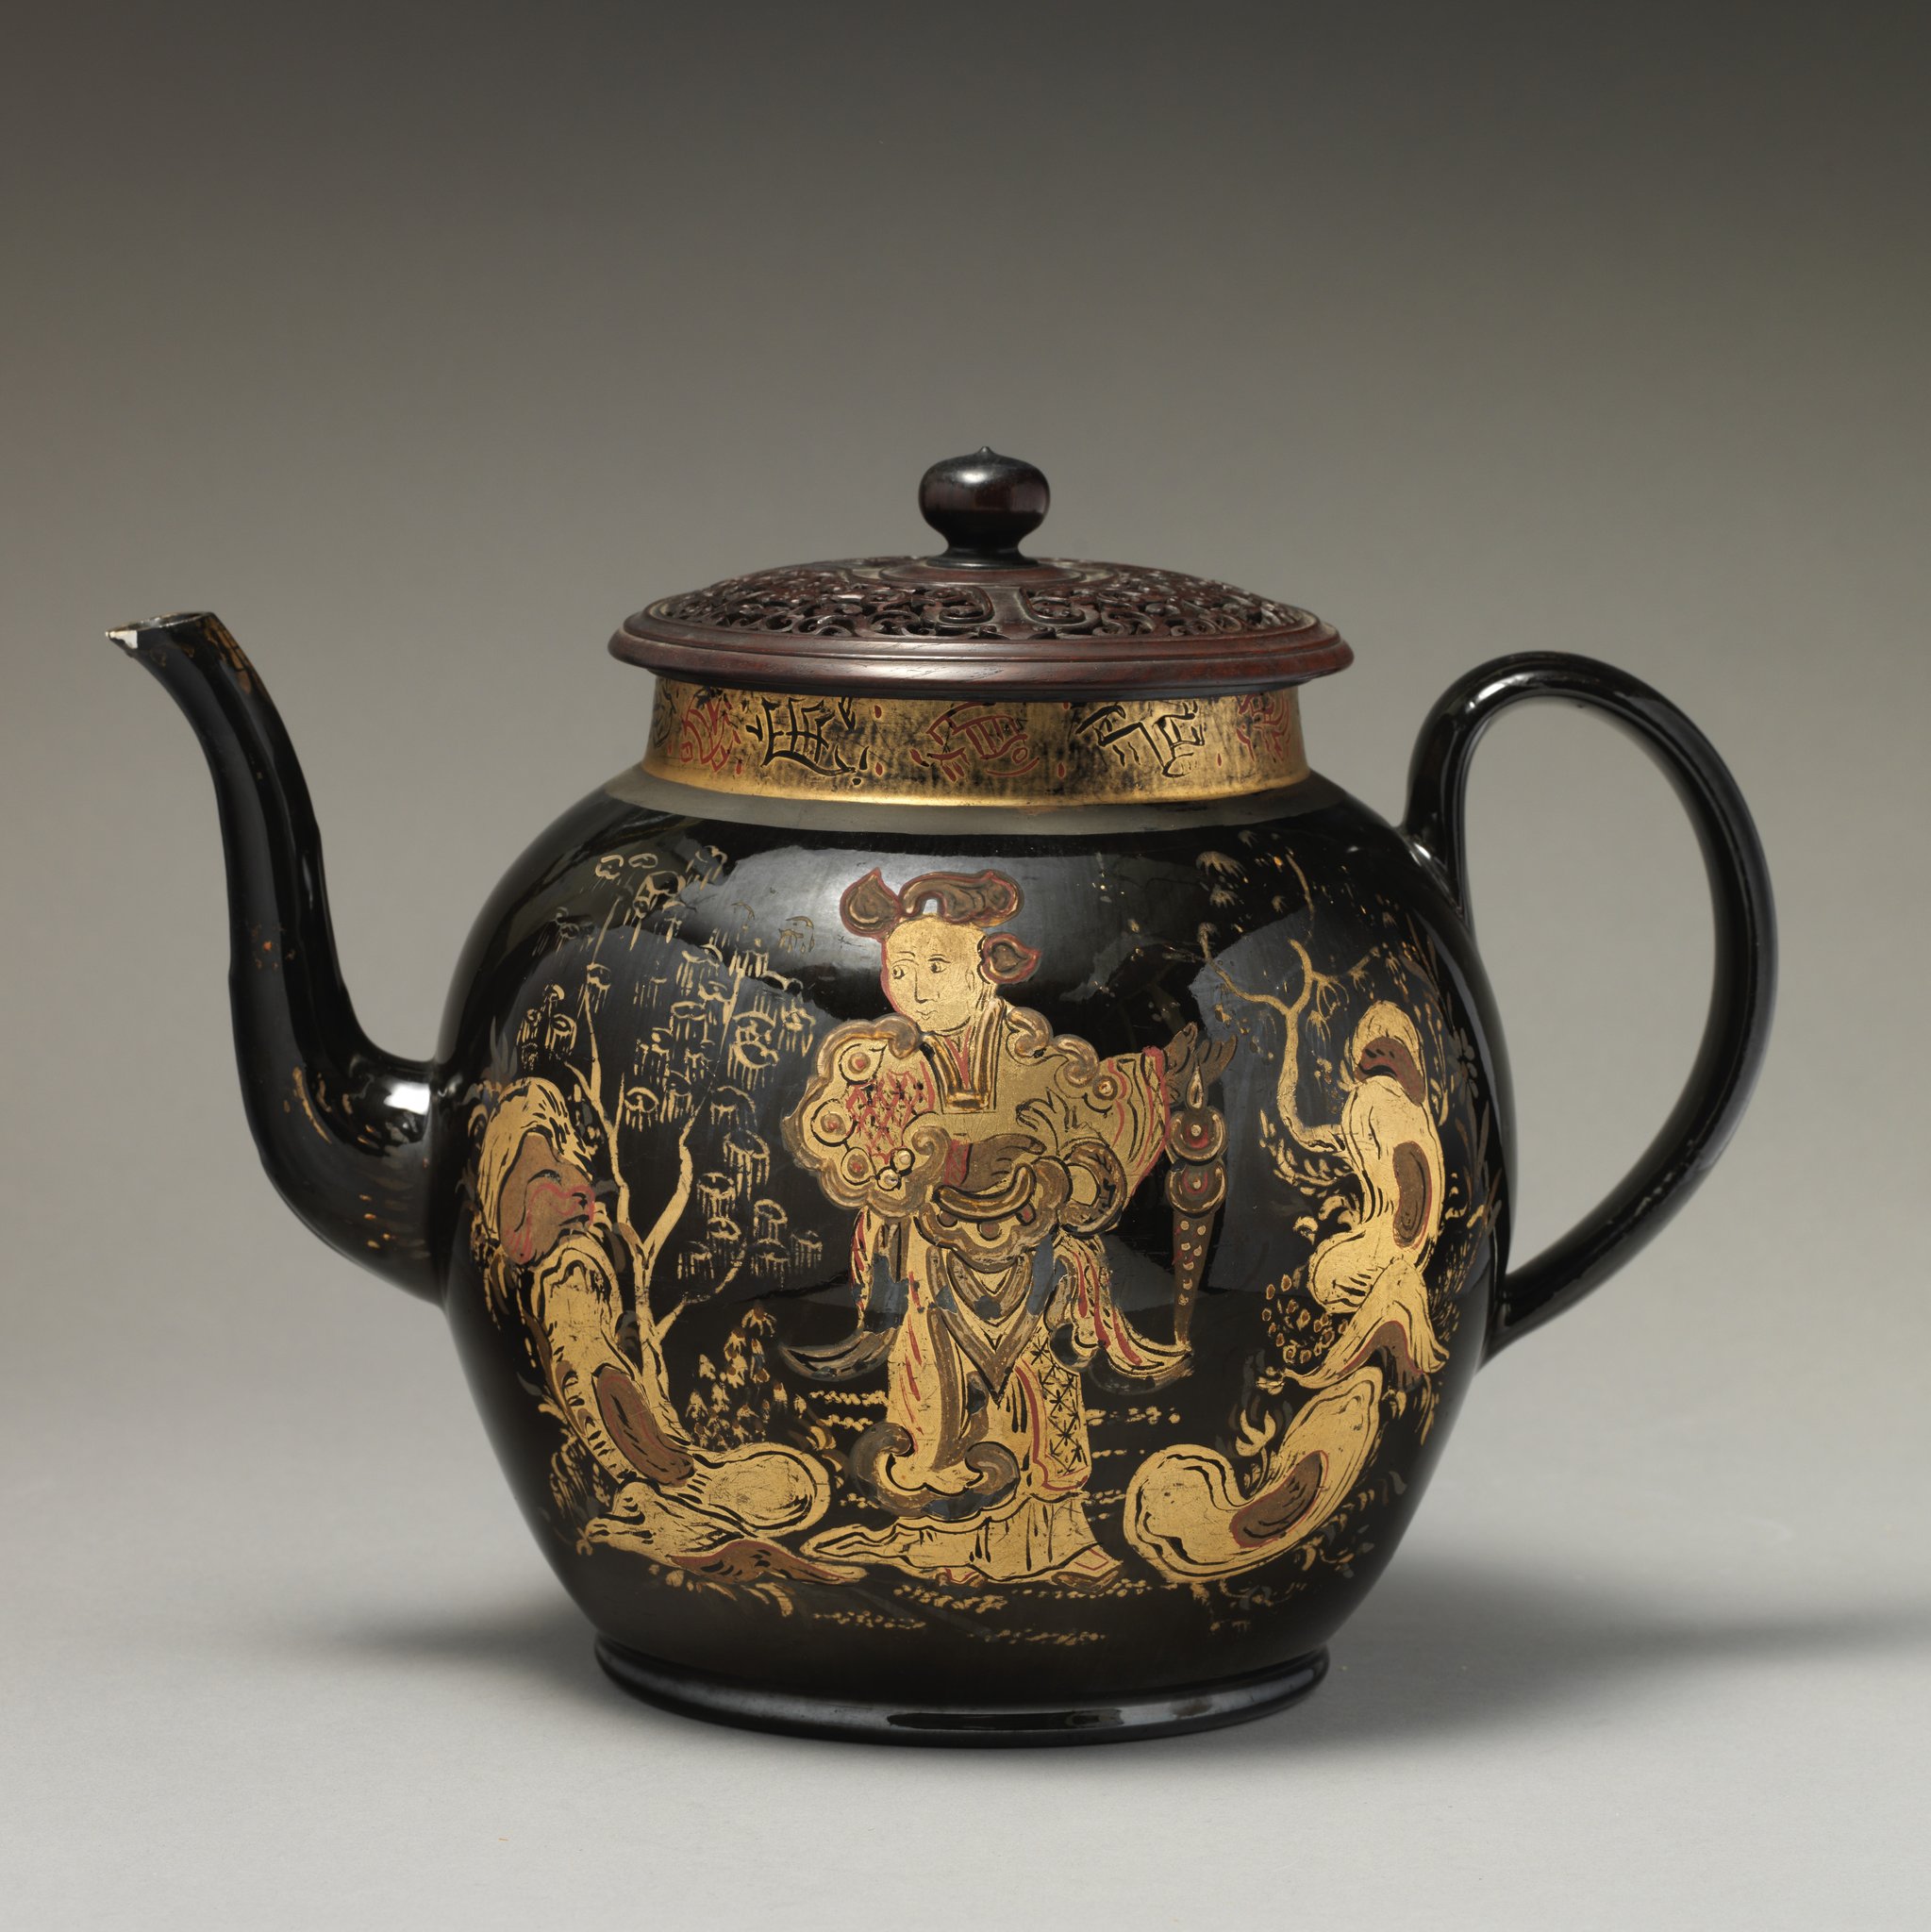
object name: punch pot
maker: jackfield pottery, shropshire, england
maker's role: maker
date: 1760-1770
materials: earthenware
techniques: glazing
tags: chinoiserie,women